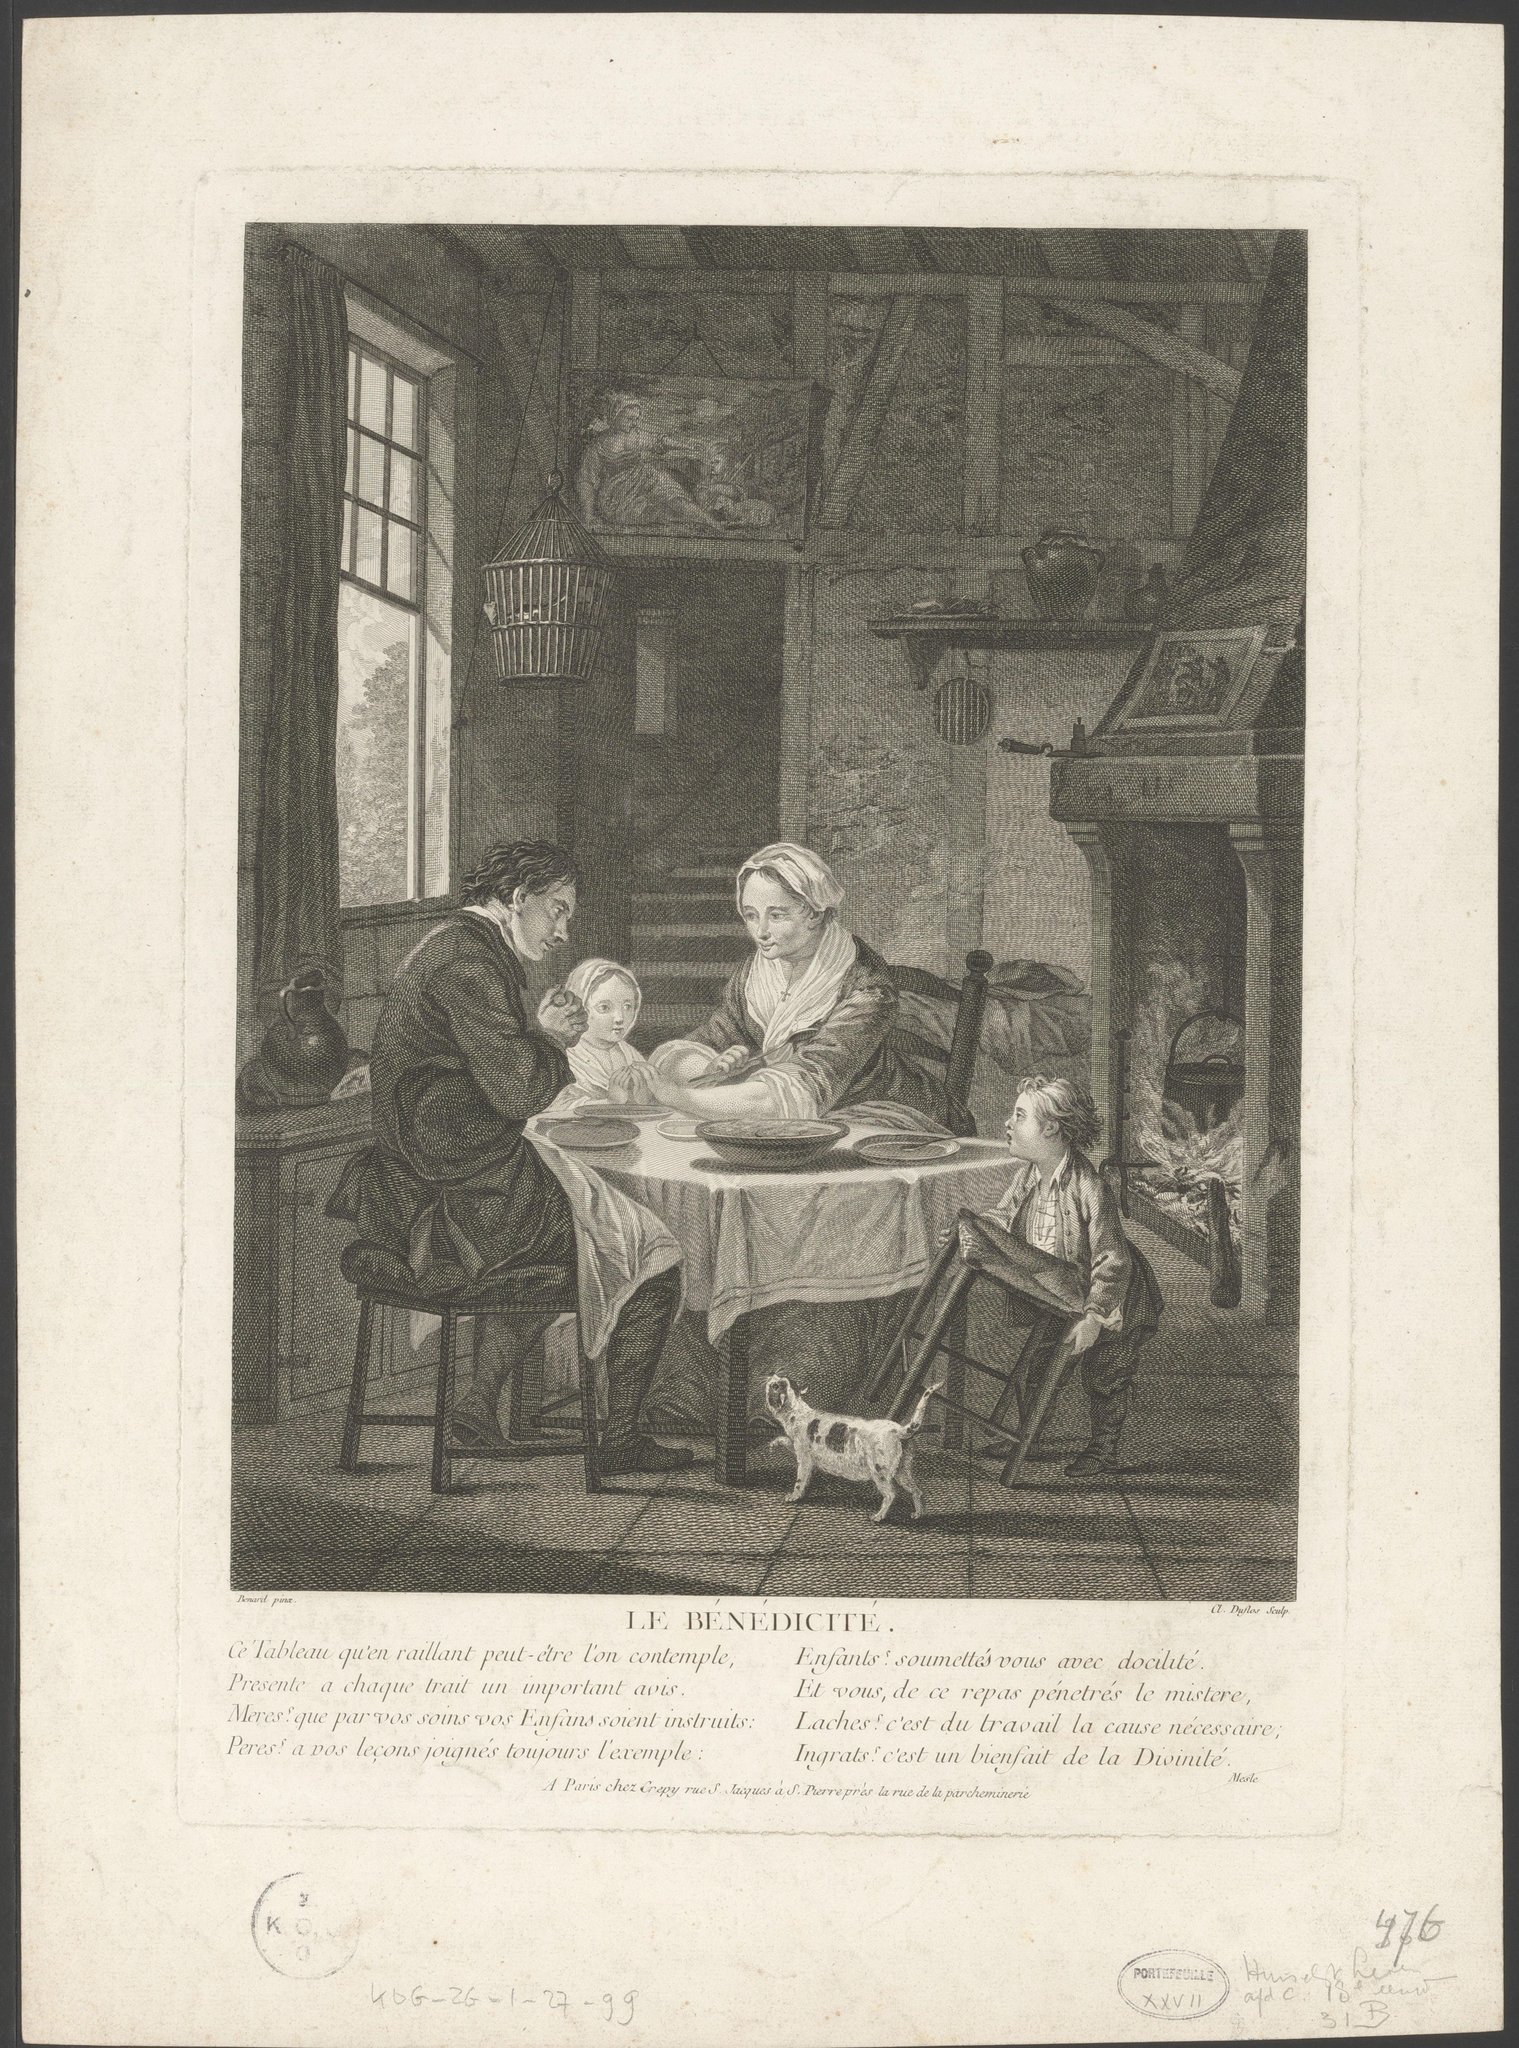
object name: print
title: Het gebed voor de maaltijd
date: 1720-1786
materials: paper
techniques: engraving, etching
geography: paris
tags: kitchen, communal rooms, family life at home, prayer at table, saying grace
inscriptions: collector's mark, collector's mark: Lugt 1641